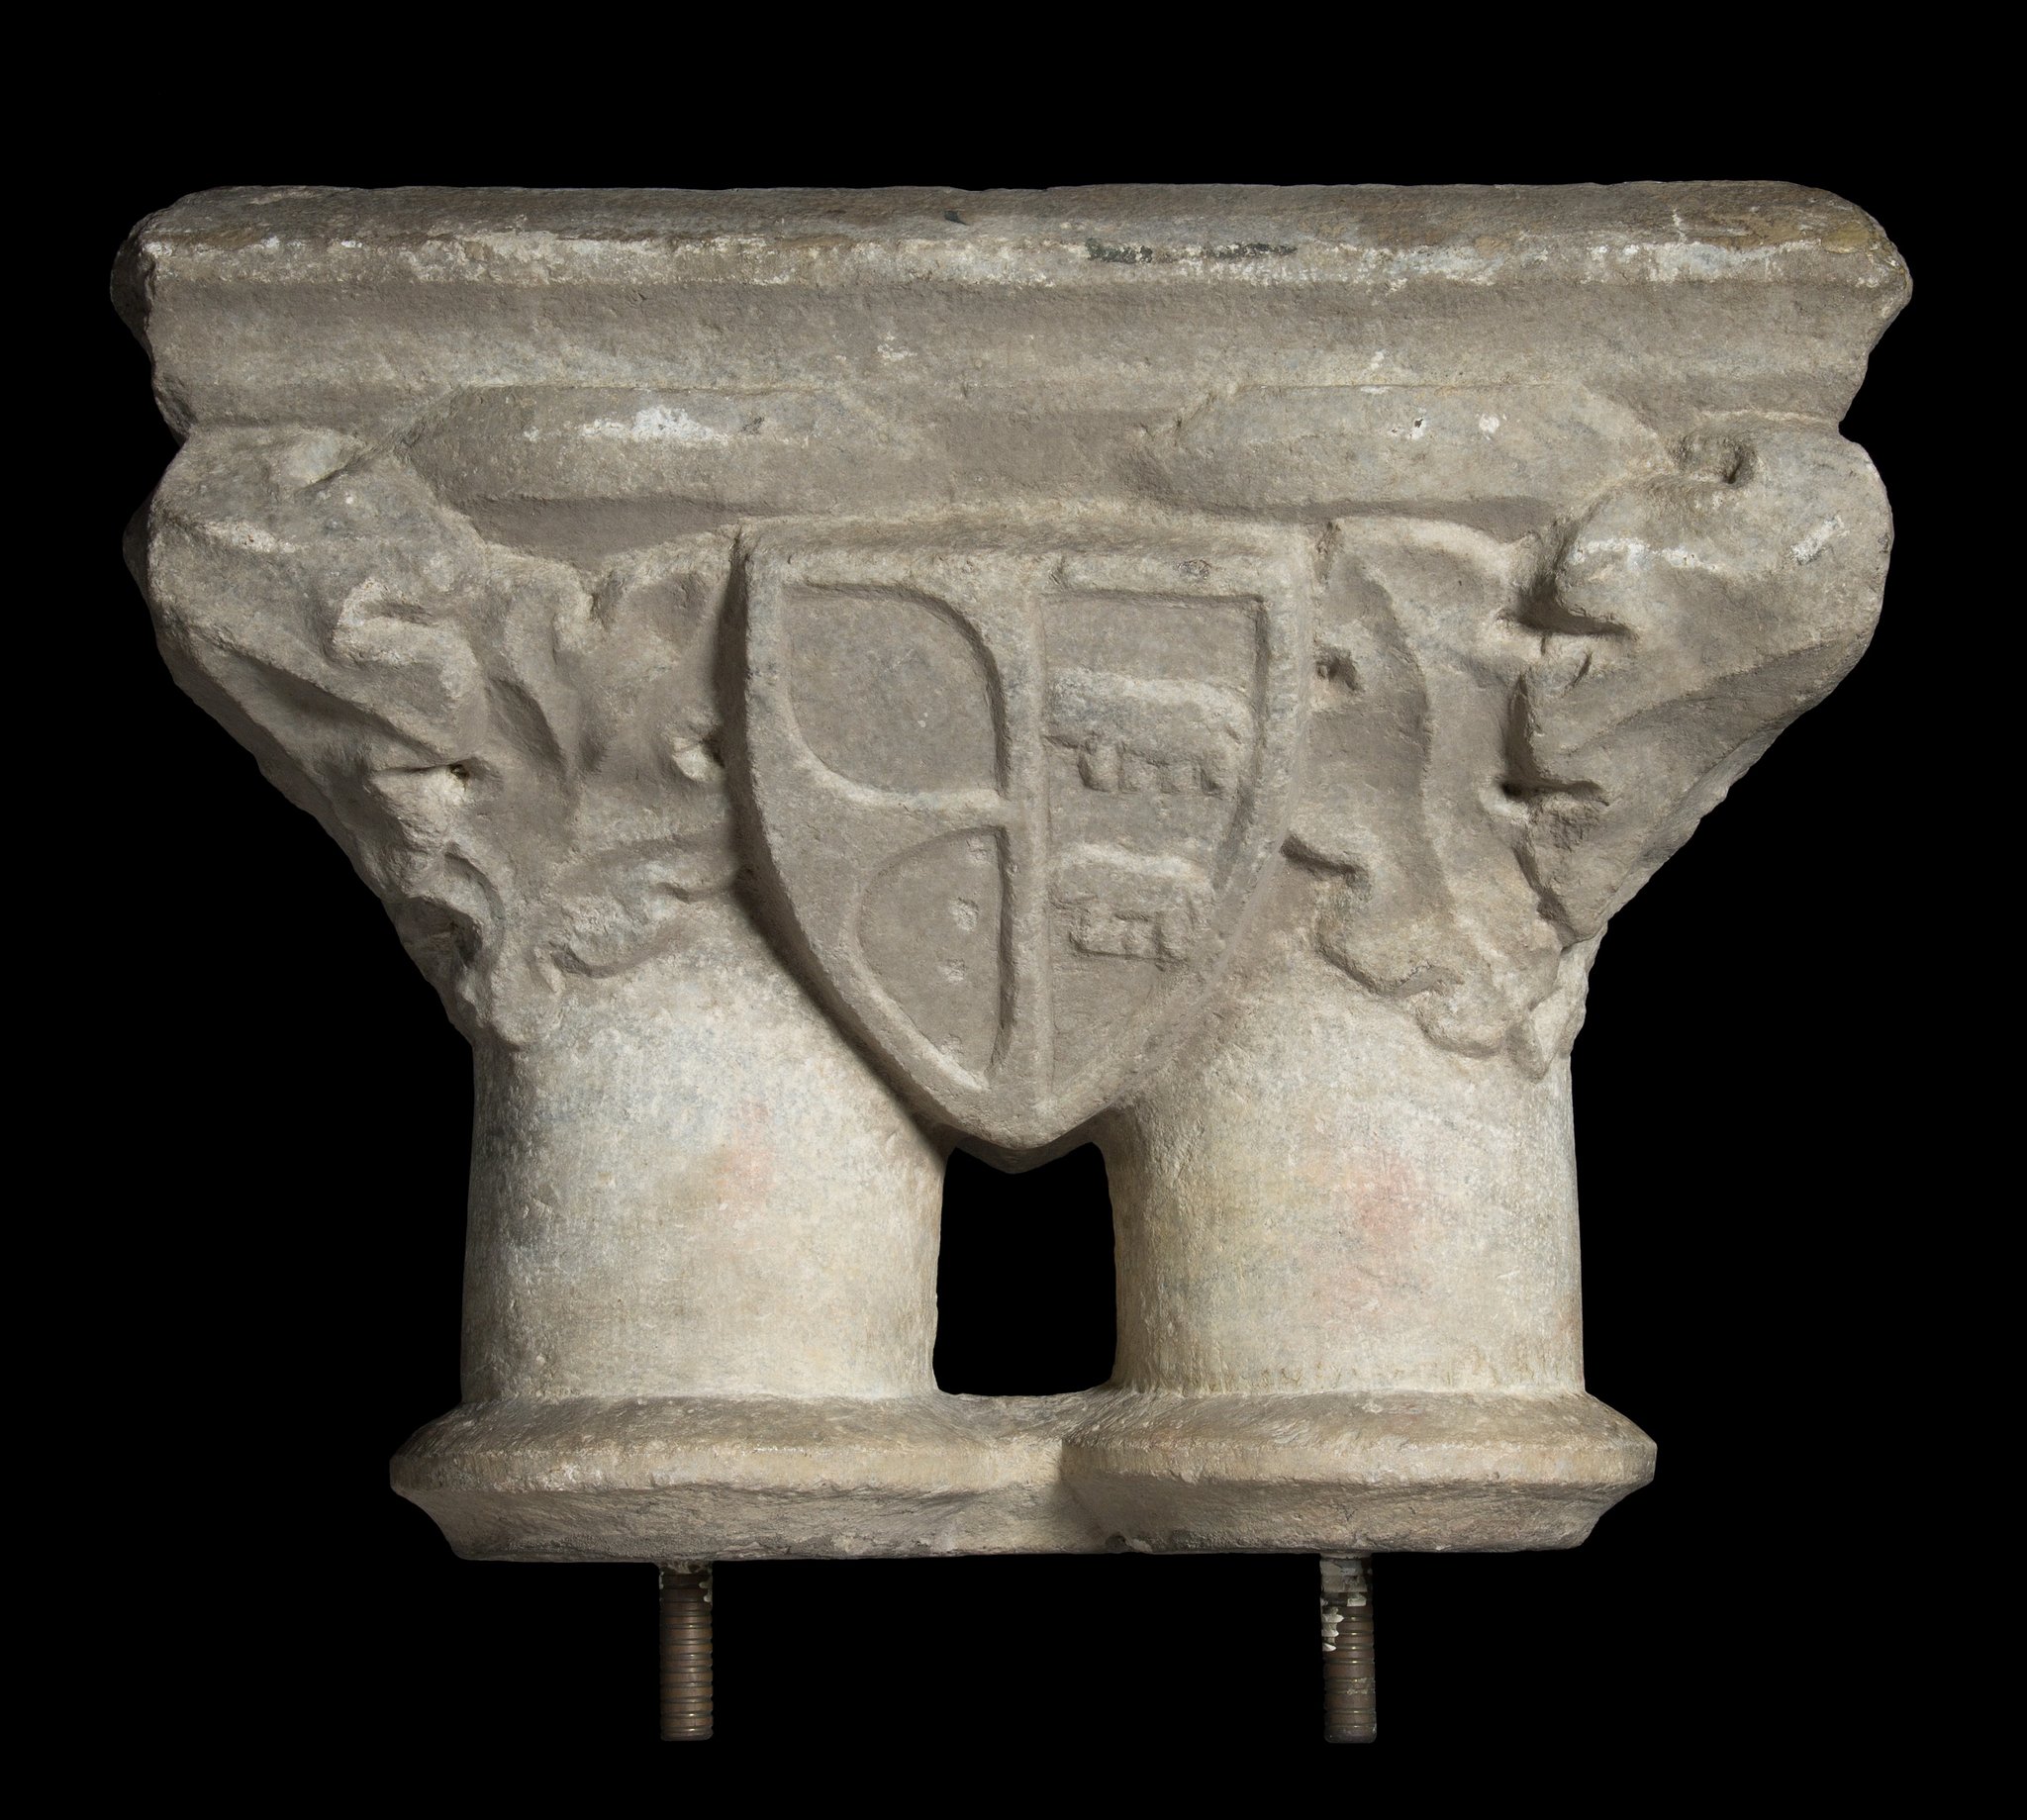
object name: double column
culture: french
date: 1201-1400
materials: marble